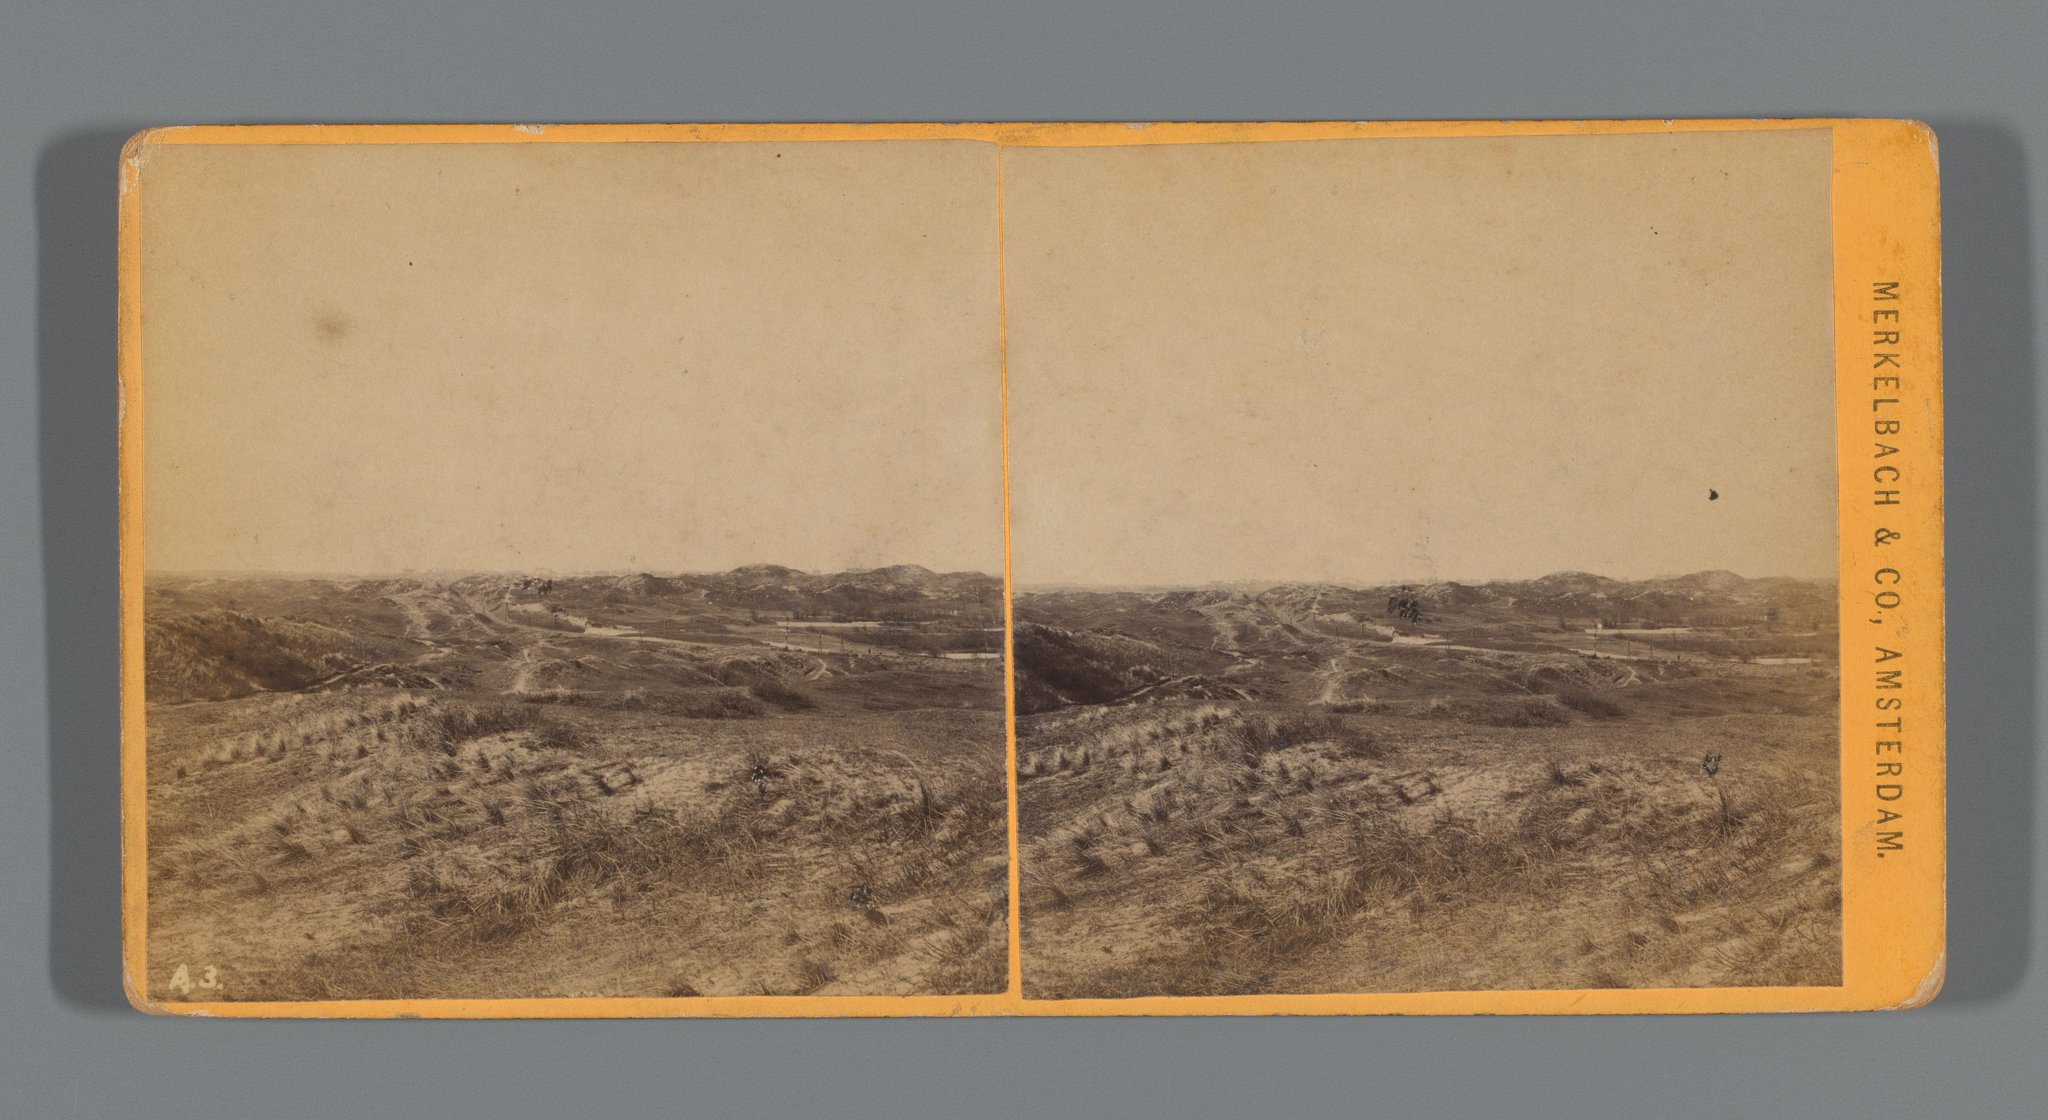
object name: stereograph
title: Aardrijkskundige Beeldengalerij, verzameld door M.J. Broekhuijsen, Hoofd eener school te Amsterdam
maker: martien johan broekhuijsen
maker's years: 1871-1956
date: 1905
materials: photographic support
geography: amsterdam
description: Onderdeel van een groep van 52 stereofoto's gebruikt in het lager onderwijs als aanvulling op schoolplaten. De gehele reeks bestond uit 274 nummers in 10 categorieën (A t/m K).